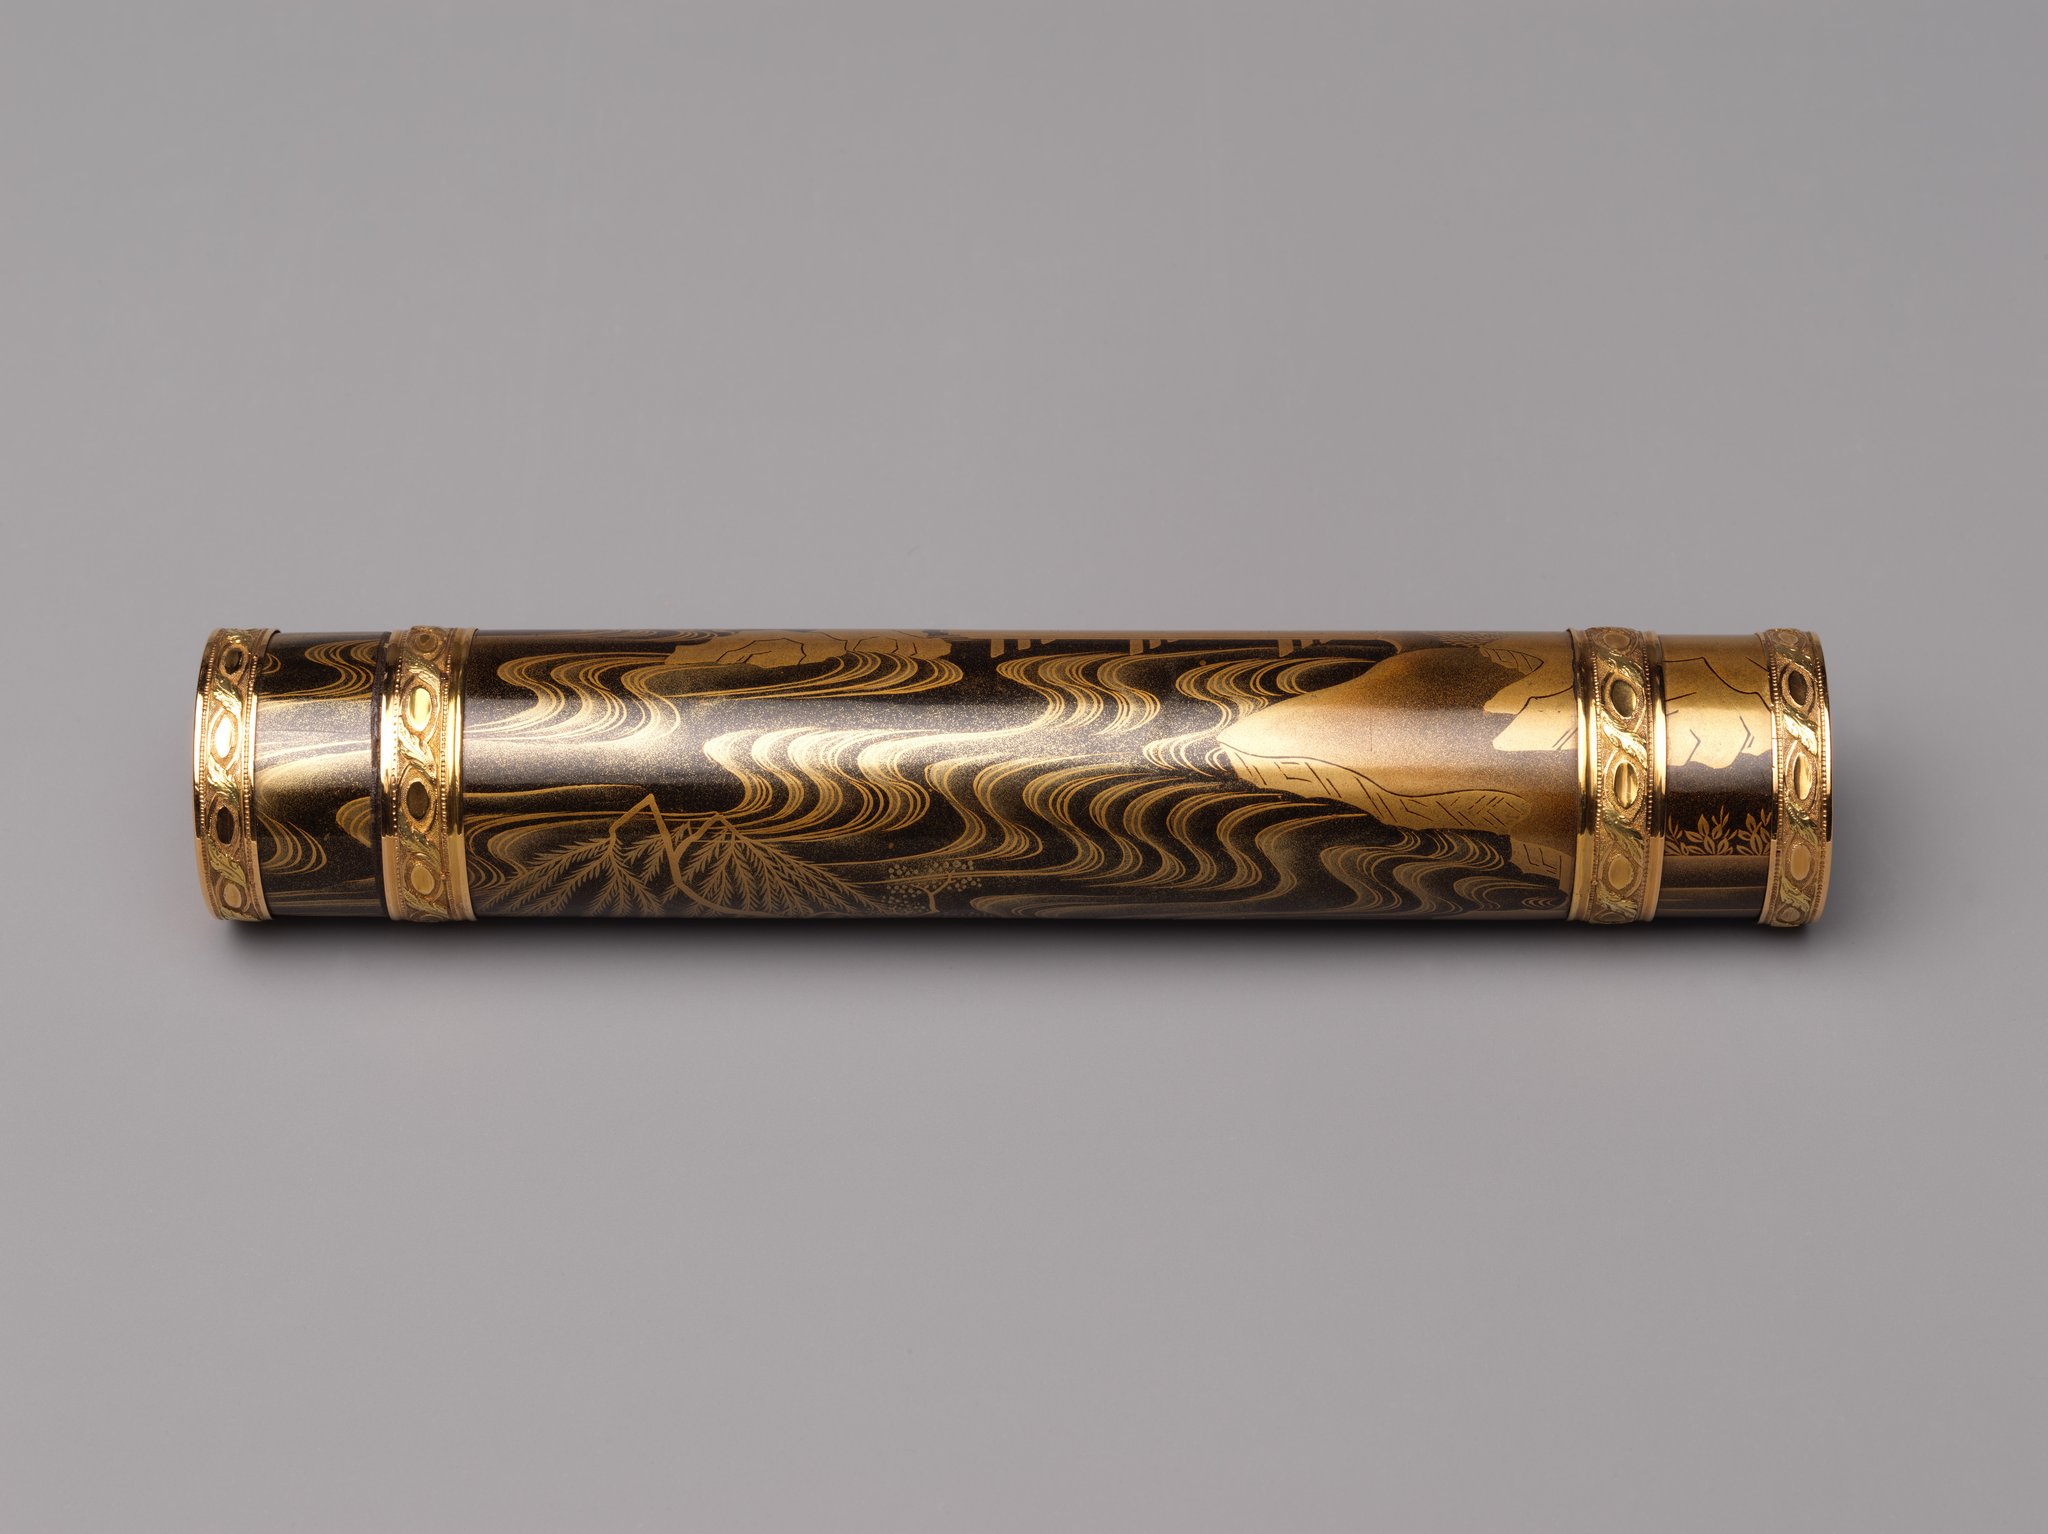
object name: message case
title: Message Case with Landscape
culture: french or japanese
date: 1734-1766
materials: gold, silver, wood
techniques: gilding, hiramakie, lacquer